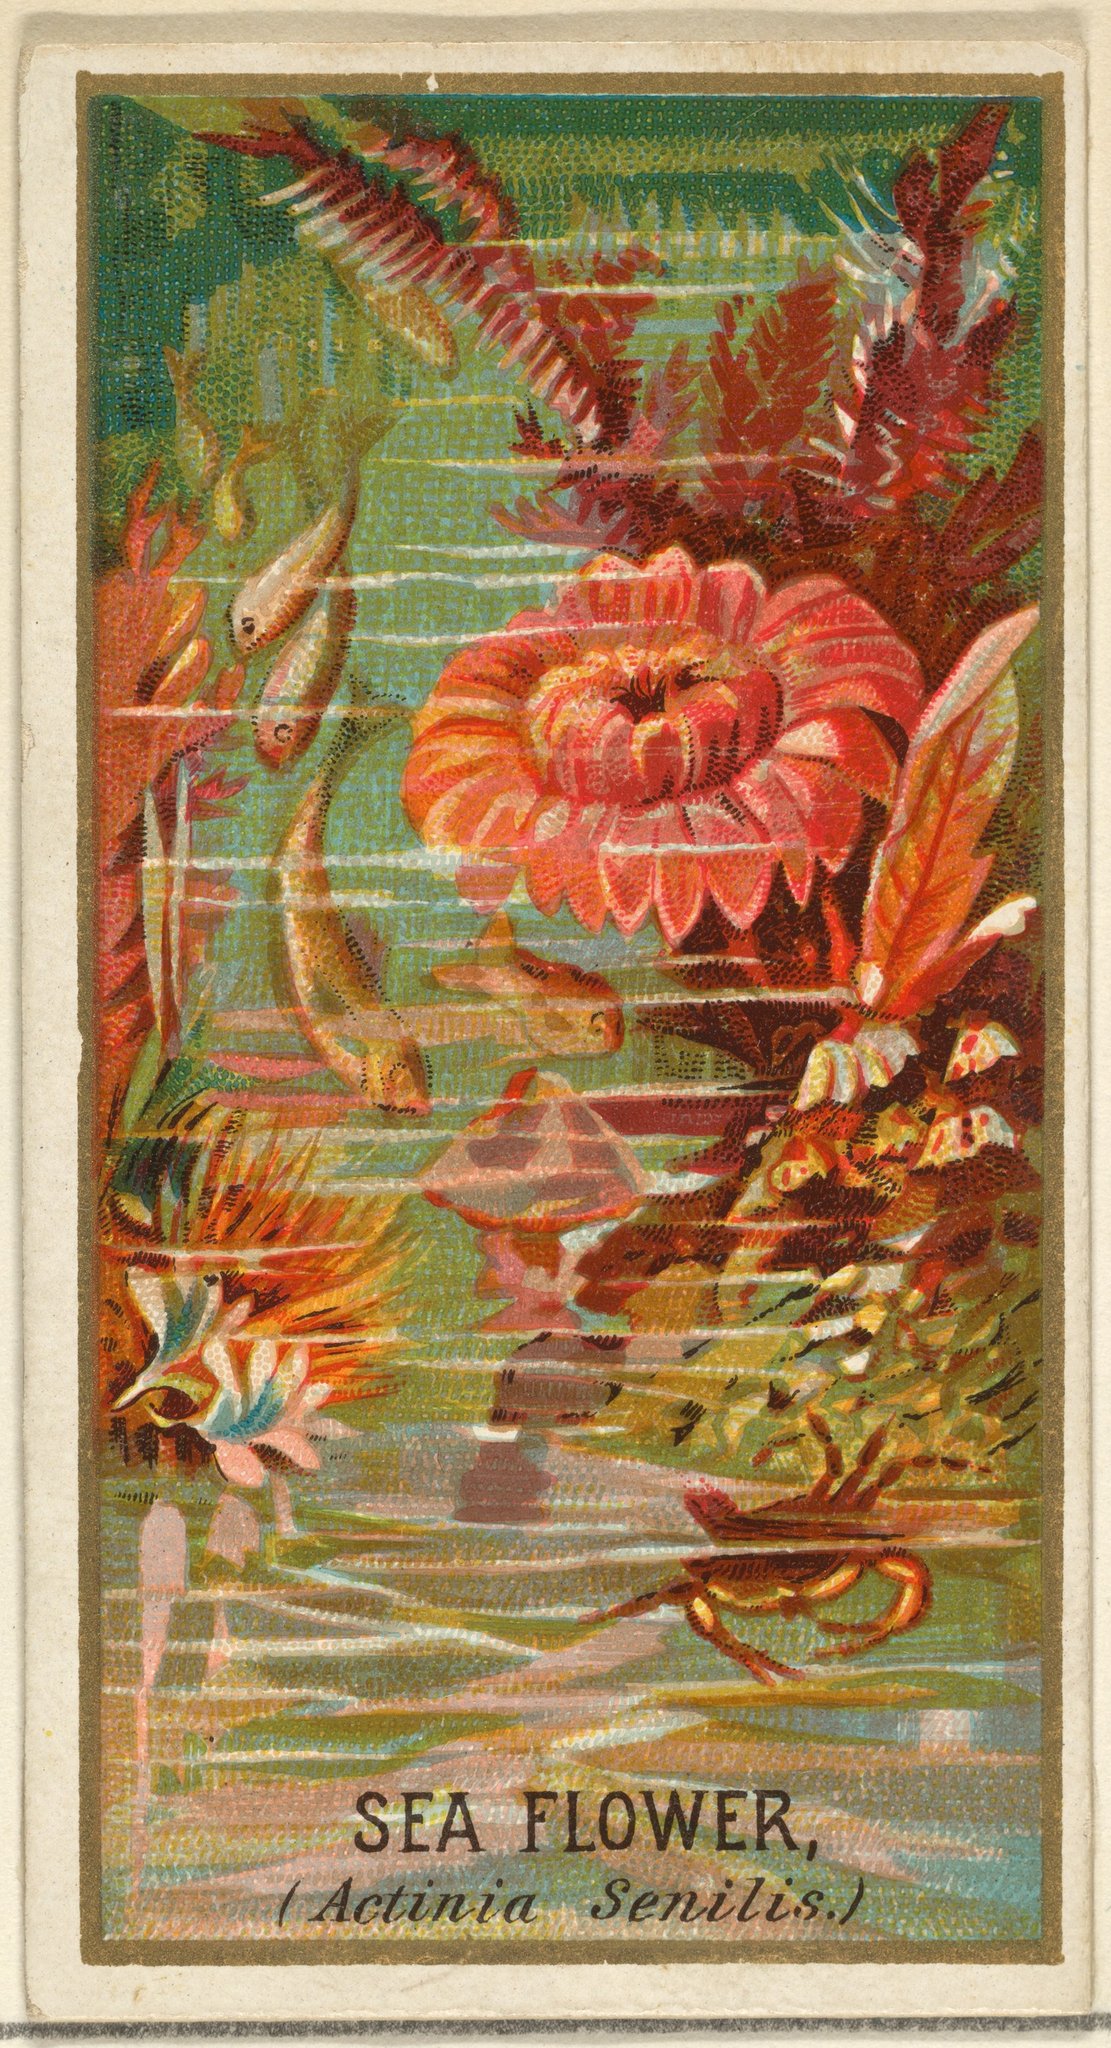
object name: print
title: Sea Flower (Actinia Senilis), from the Flowers series for Old Judge Cigarettes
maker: goodwin & company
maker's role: publisher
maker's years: 1850-1950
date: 1890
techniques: color lithograph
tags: crabs,fish,flowers